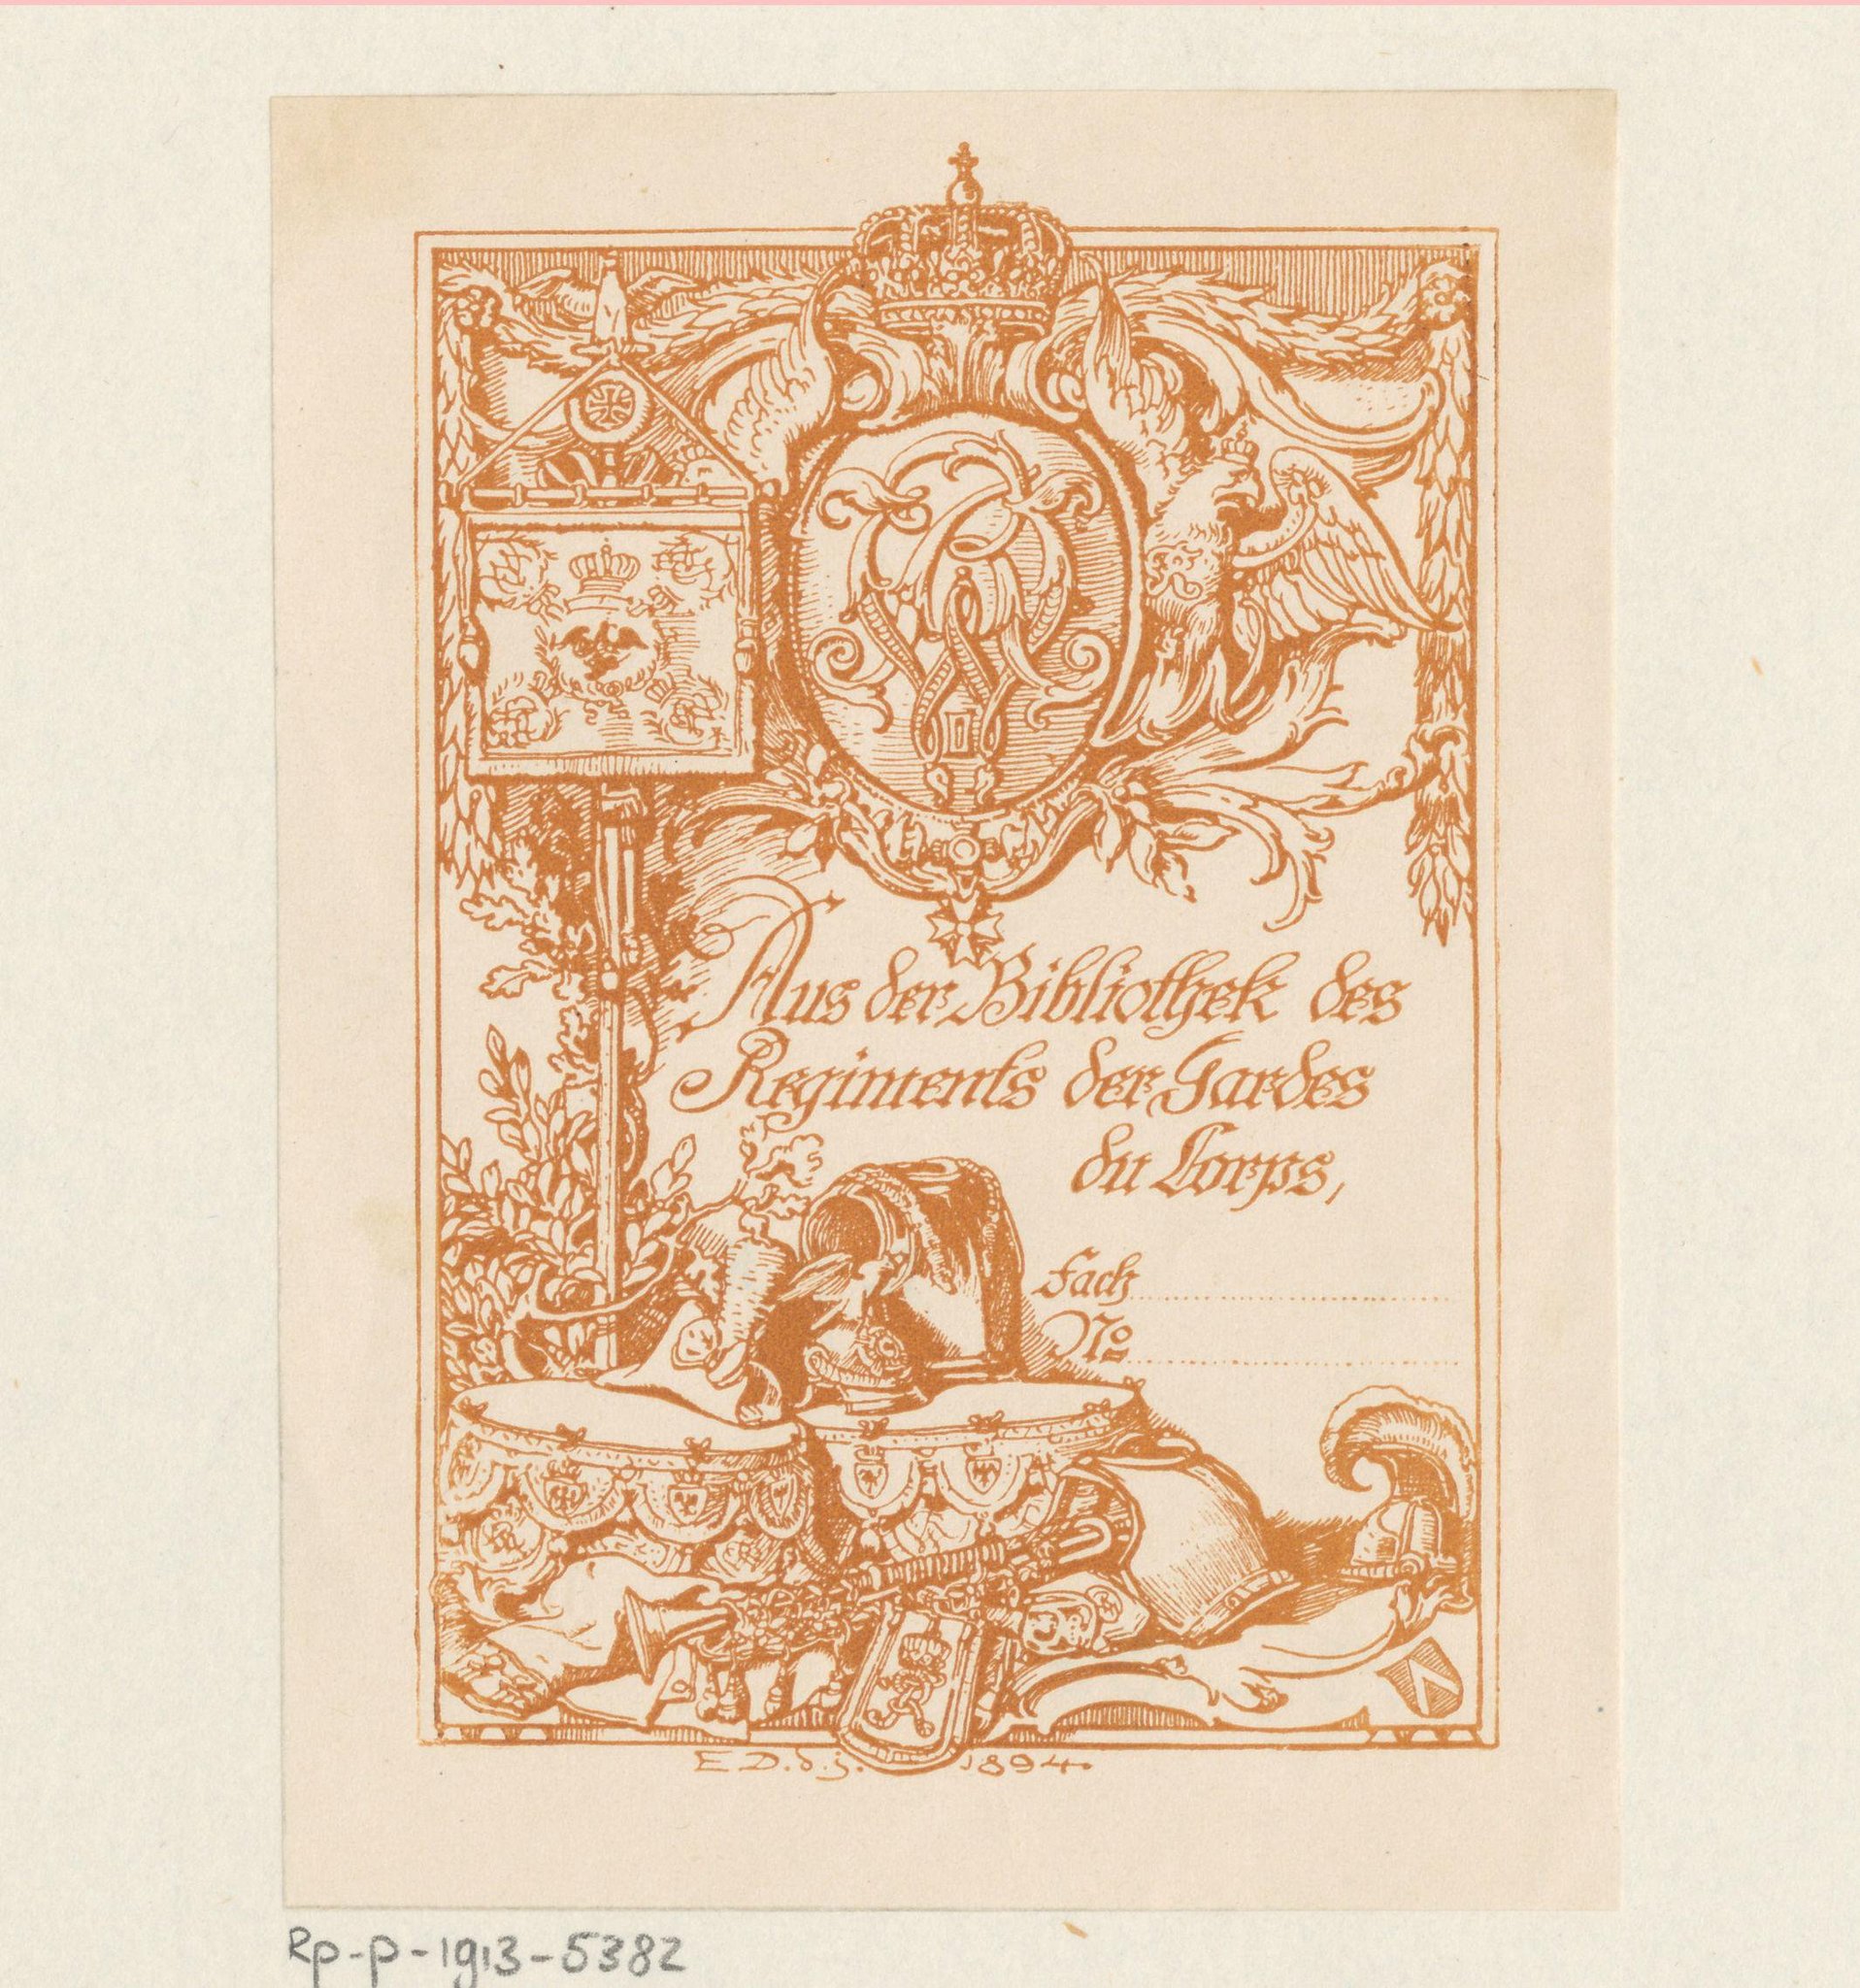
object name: photomechanical print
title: Ex libris van Bibliothek des Regiments der Gardes de Corps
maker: Anonymous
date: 1894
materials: paper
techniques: printing block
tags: military clothing and other equipment (uniforms, cap, armour, helmet, etc.), armorial bearing, heraldry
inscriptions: collector's mark: Lugt 2760, monogram: ‘E.D. d.j.’, collector's mark: Lugt 2233